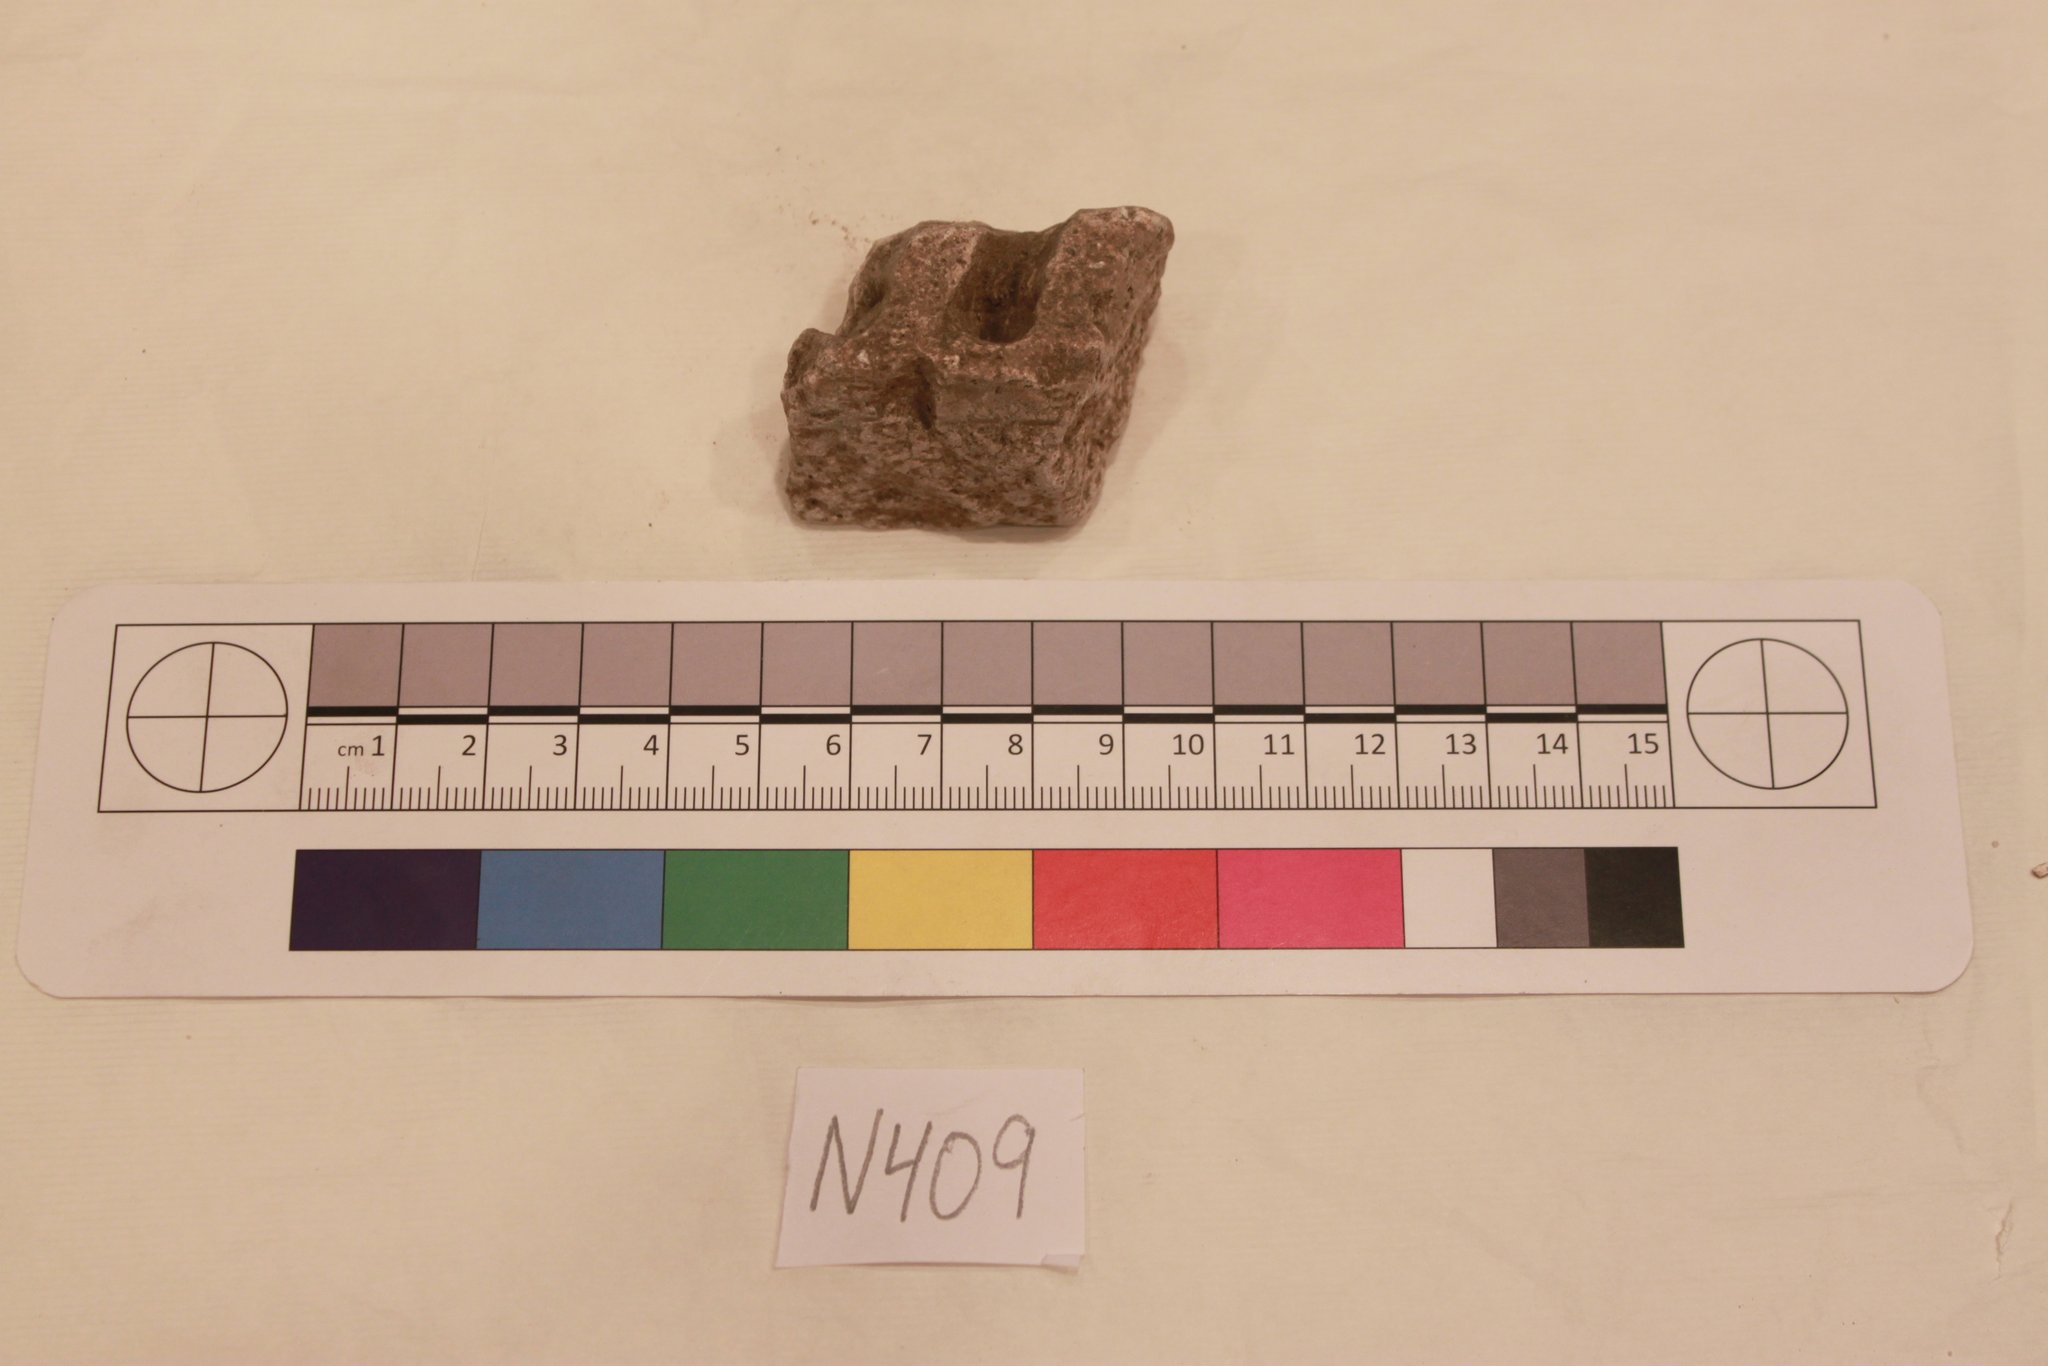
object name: fragment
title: Stucco Fragment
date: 701-1200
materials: plaster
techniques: carving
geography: iran